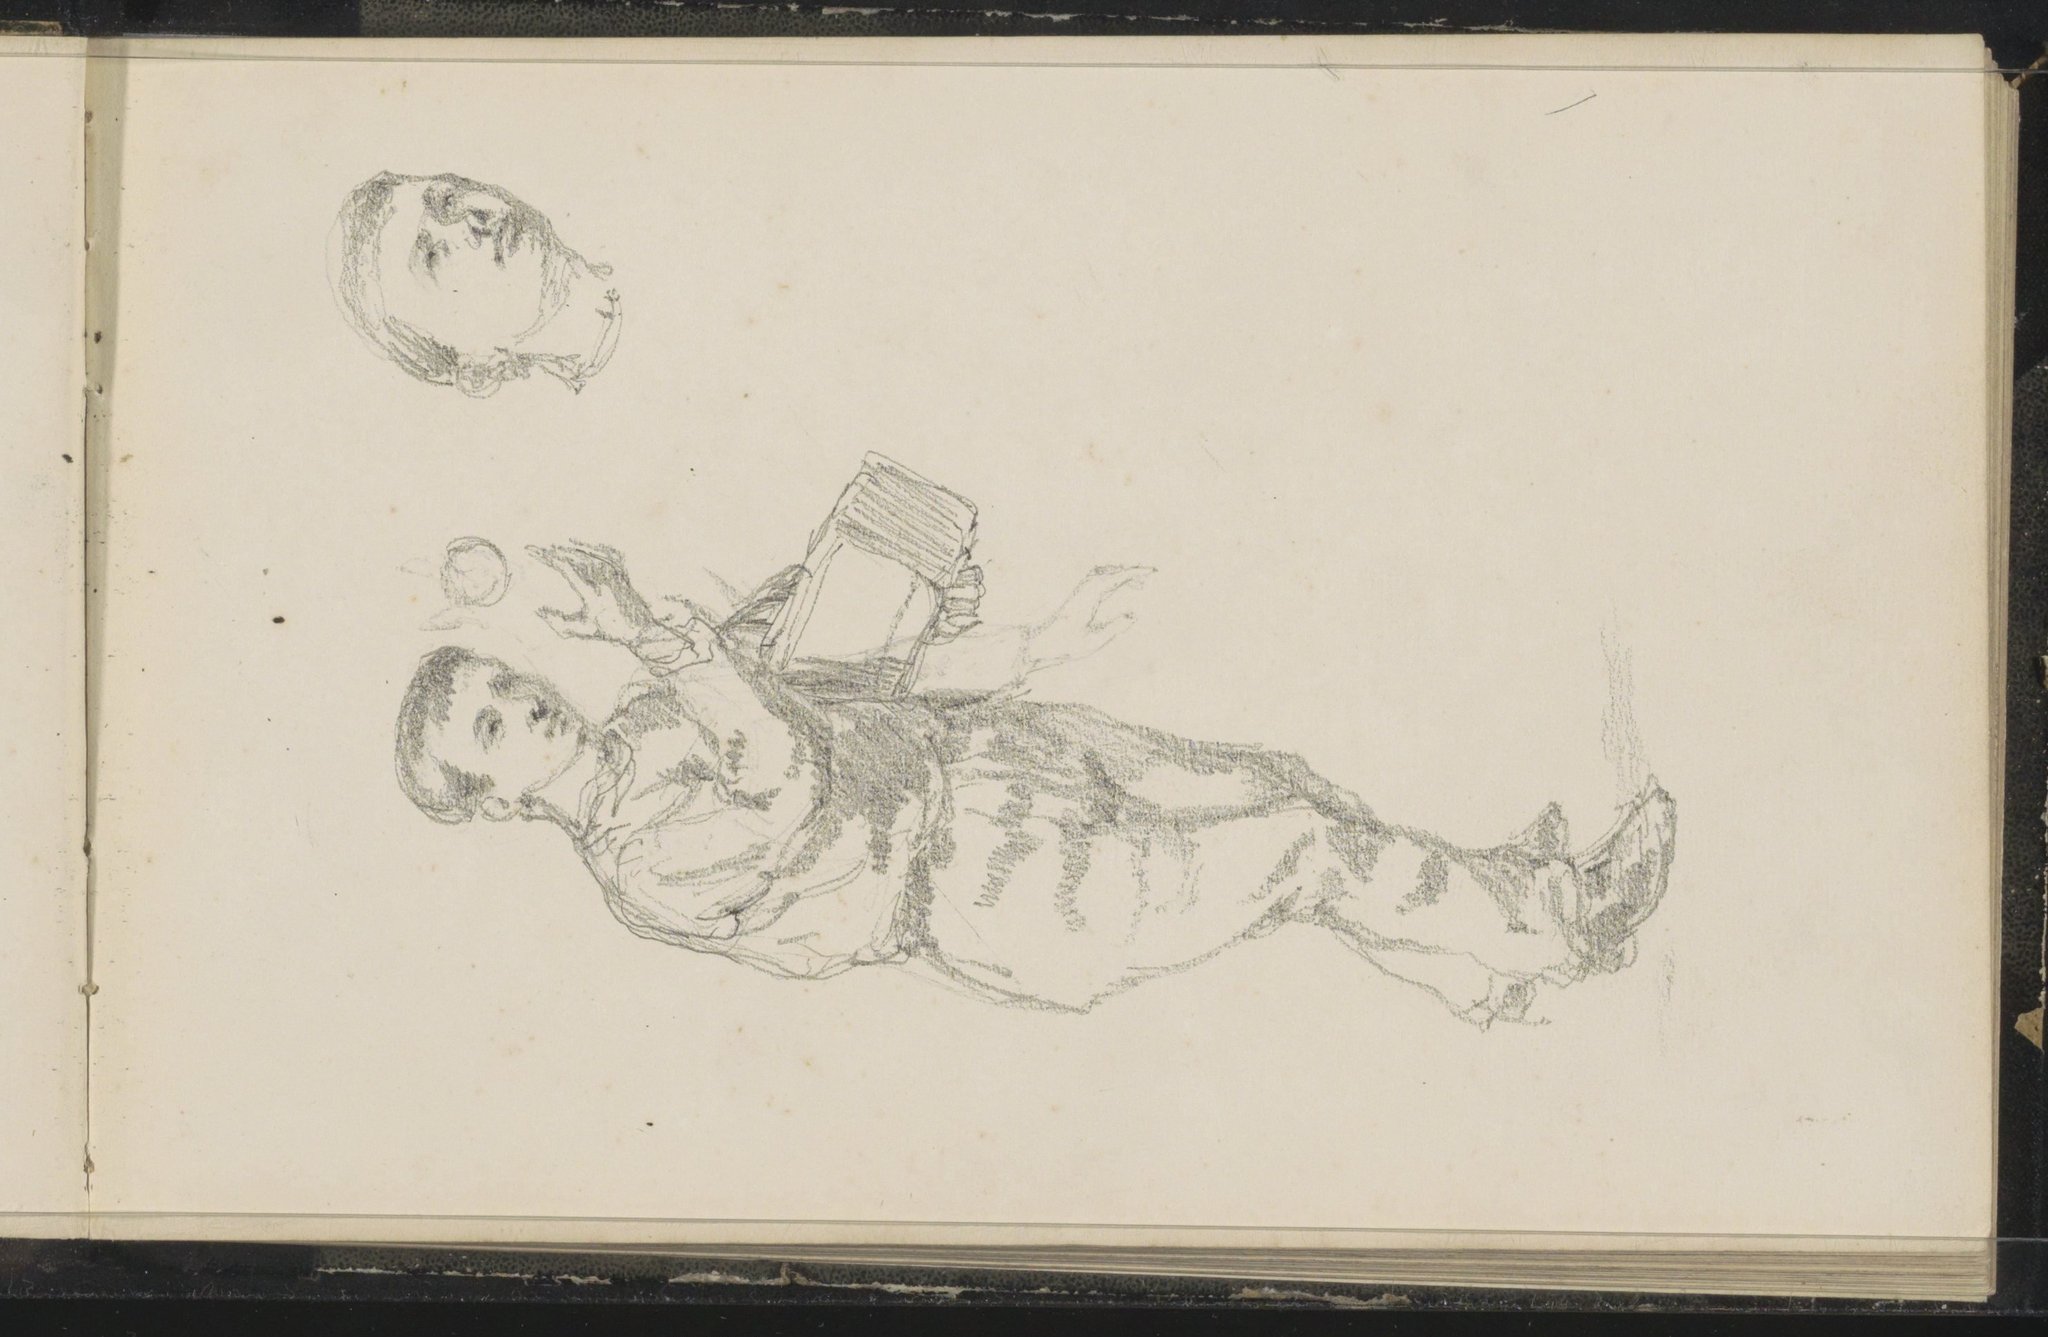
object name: sketchbook leaf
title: Mannenhoofd en een jonge man met een kist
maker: cornelis springer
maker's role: draughtsman, painter, print maker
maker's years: 1817-1891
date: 1873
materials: paper, pencil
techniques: stumping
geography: netherlands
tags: head (human), youth, adolescent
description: Links een jonge man met een kist. Hij gooit een rond voorwerp, mogelijk een appel, in de lucht. Rechts een mannenhoofd. Blad 2 uit een schetsboek met 46 bladen.